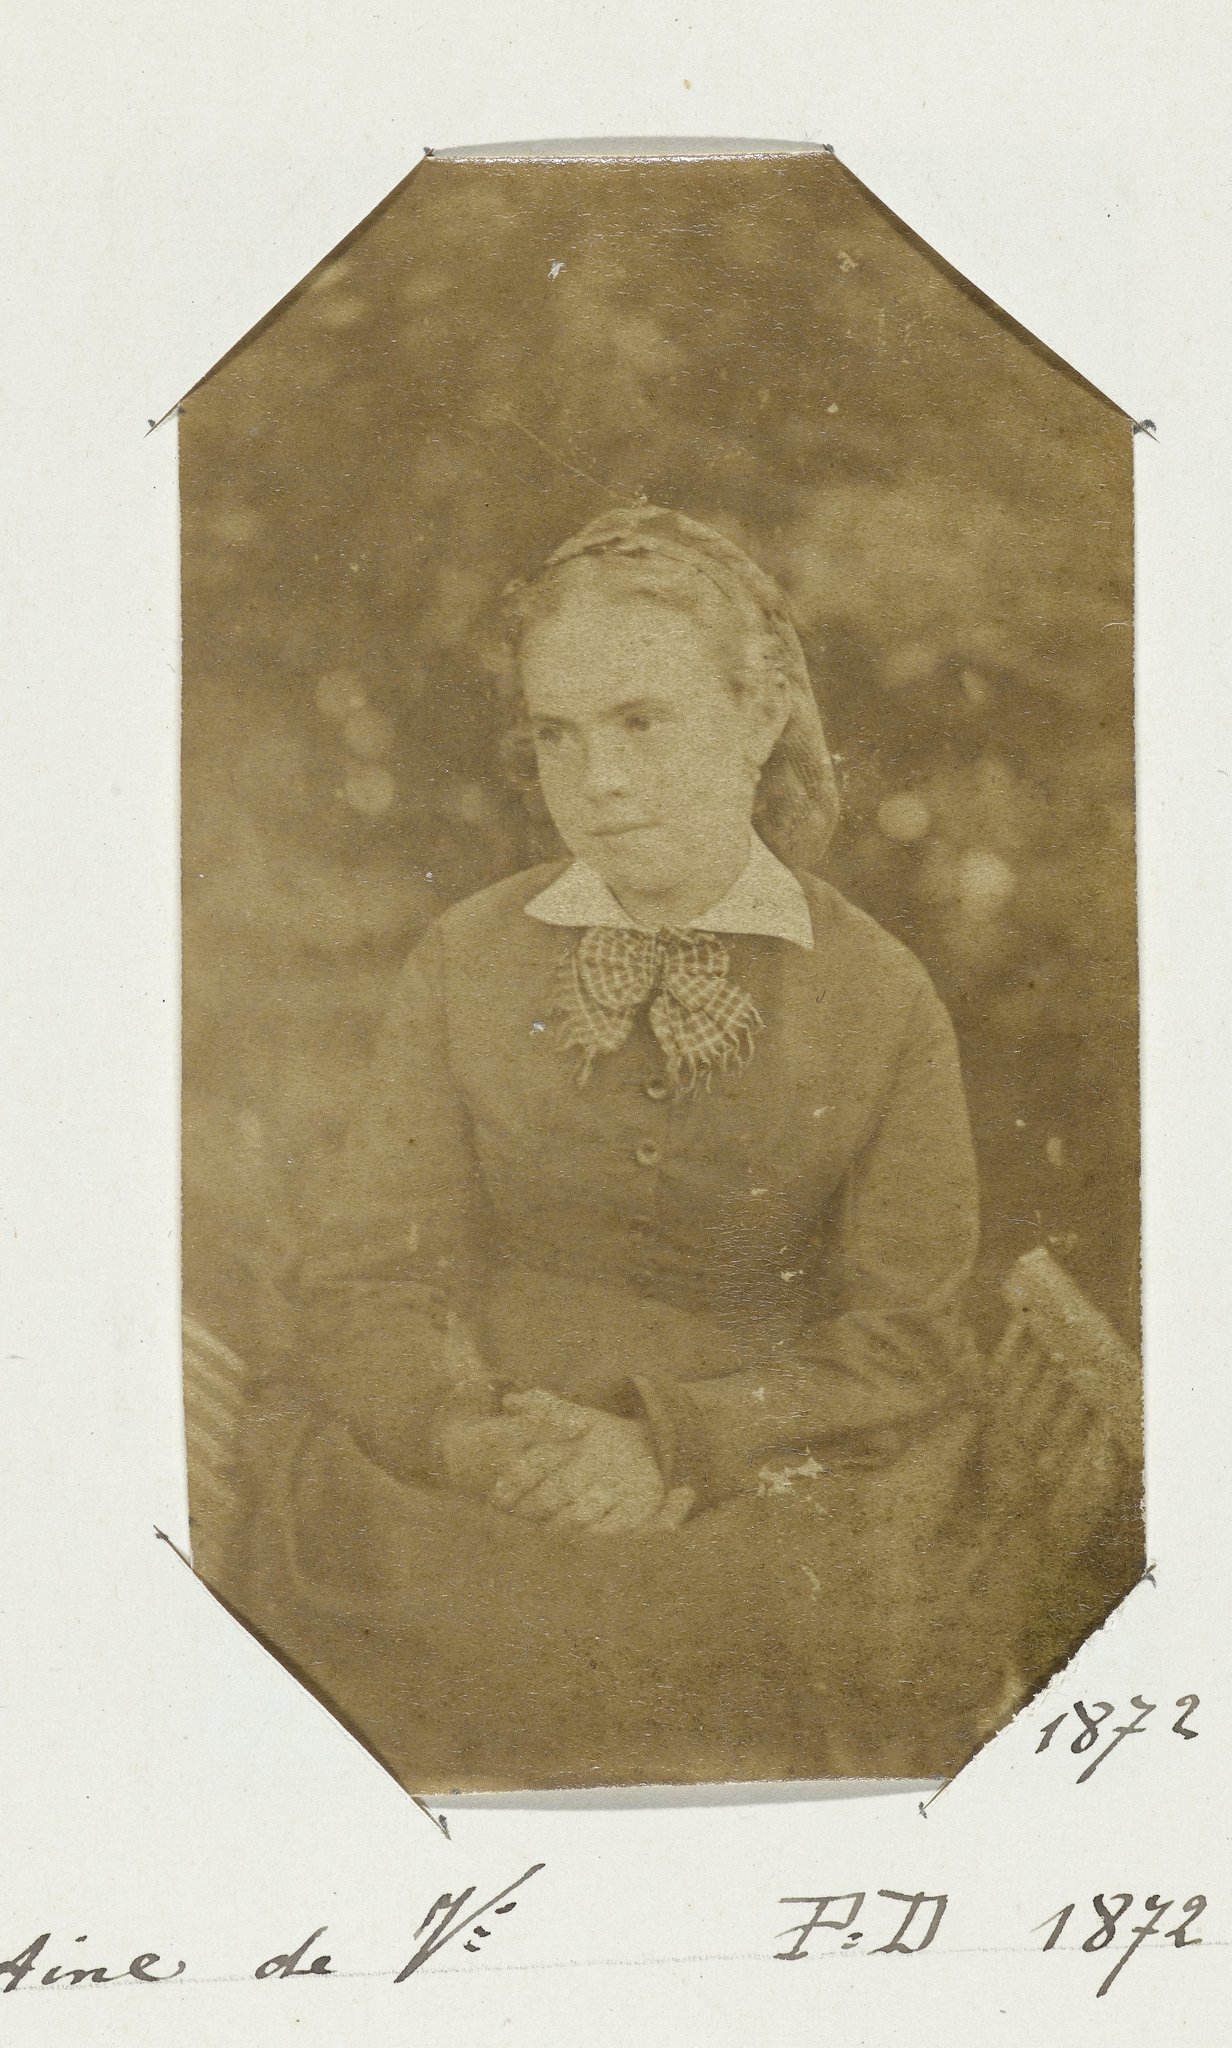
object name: photograph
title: Mademoiselle Valentine de V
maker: Anonymous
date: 1872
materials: paper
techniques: albumen print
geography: les petites-dalles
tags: historical persons - bb - woman, girl (child between toddler and youth)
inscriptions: inscription: ‘Mademoiselle Valentine de V. P.D. 1872’, inscription: ‘1872’